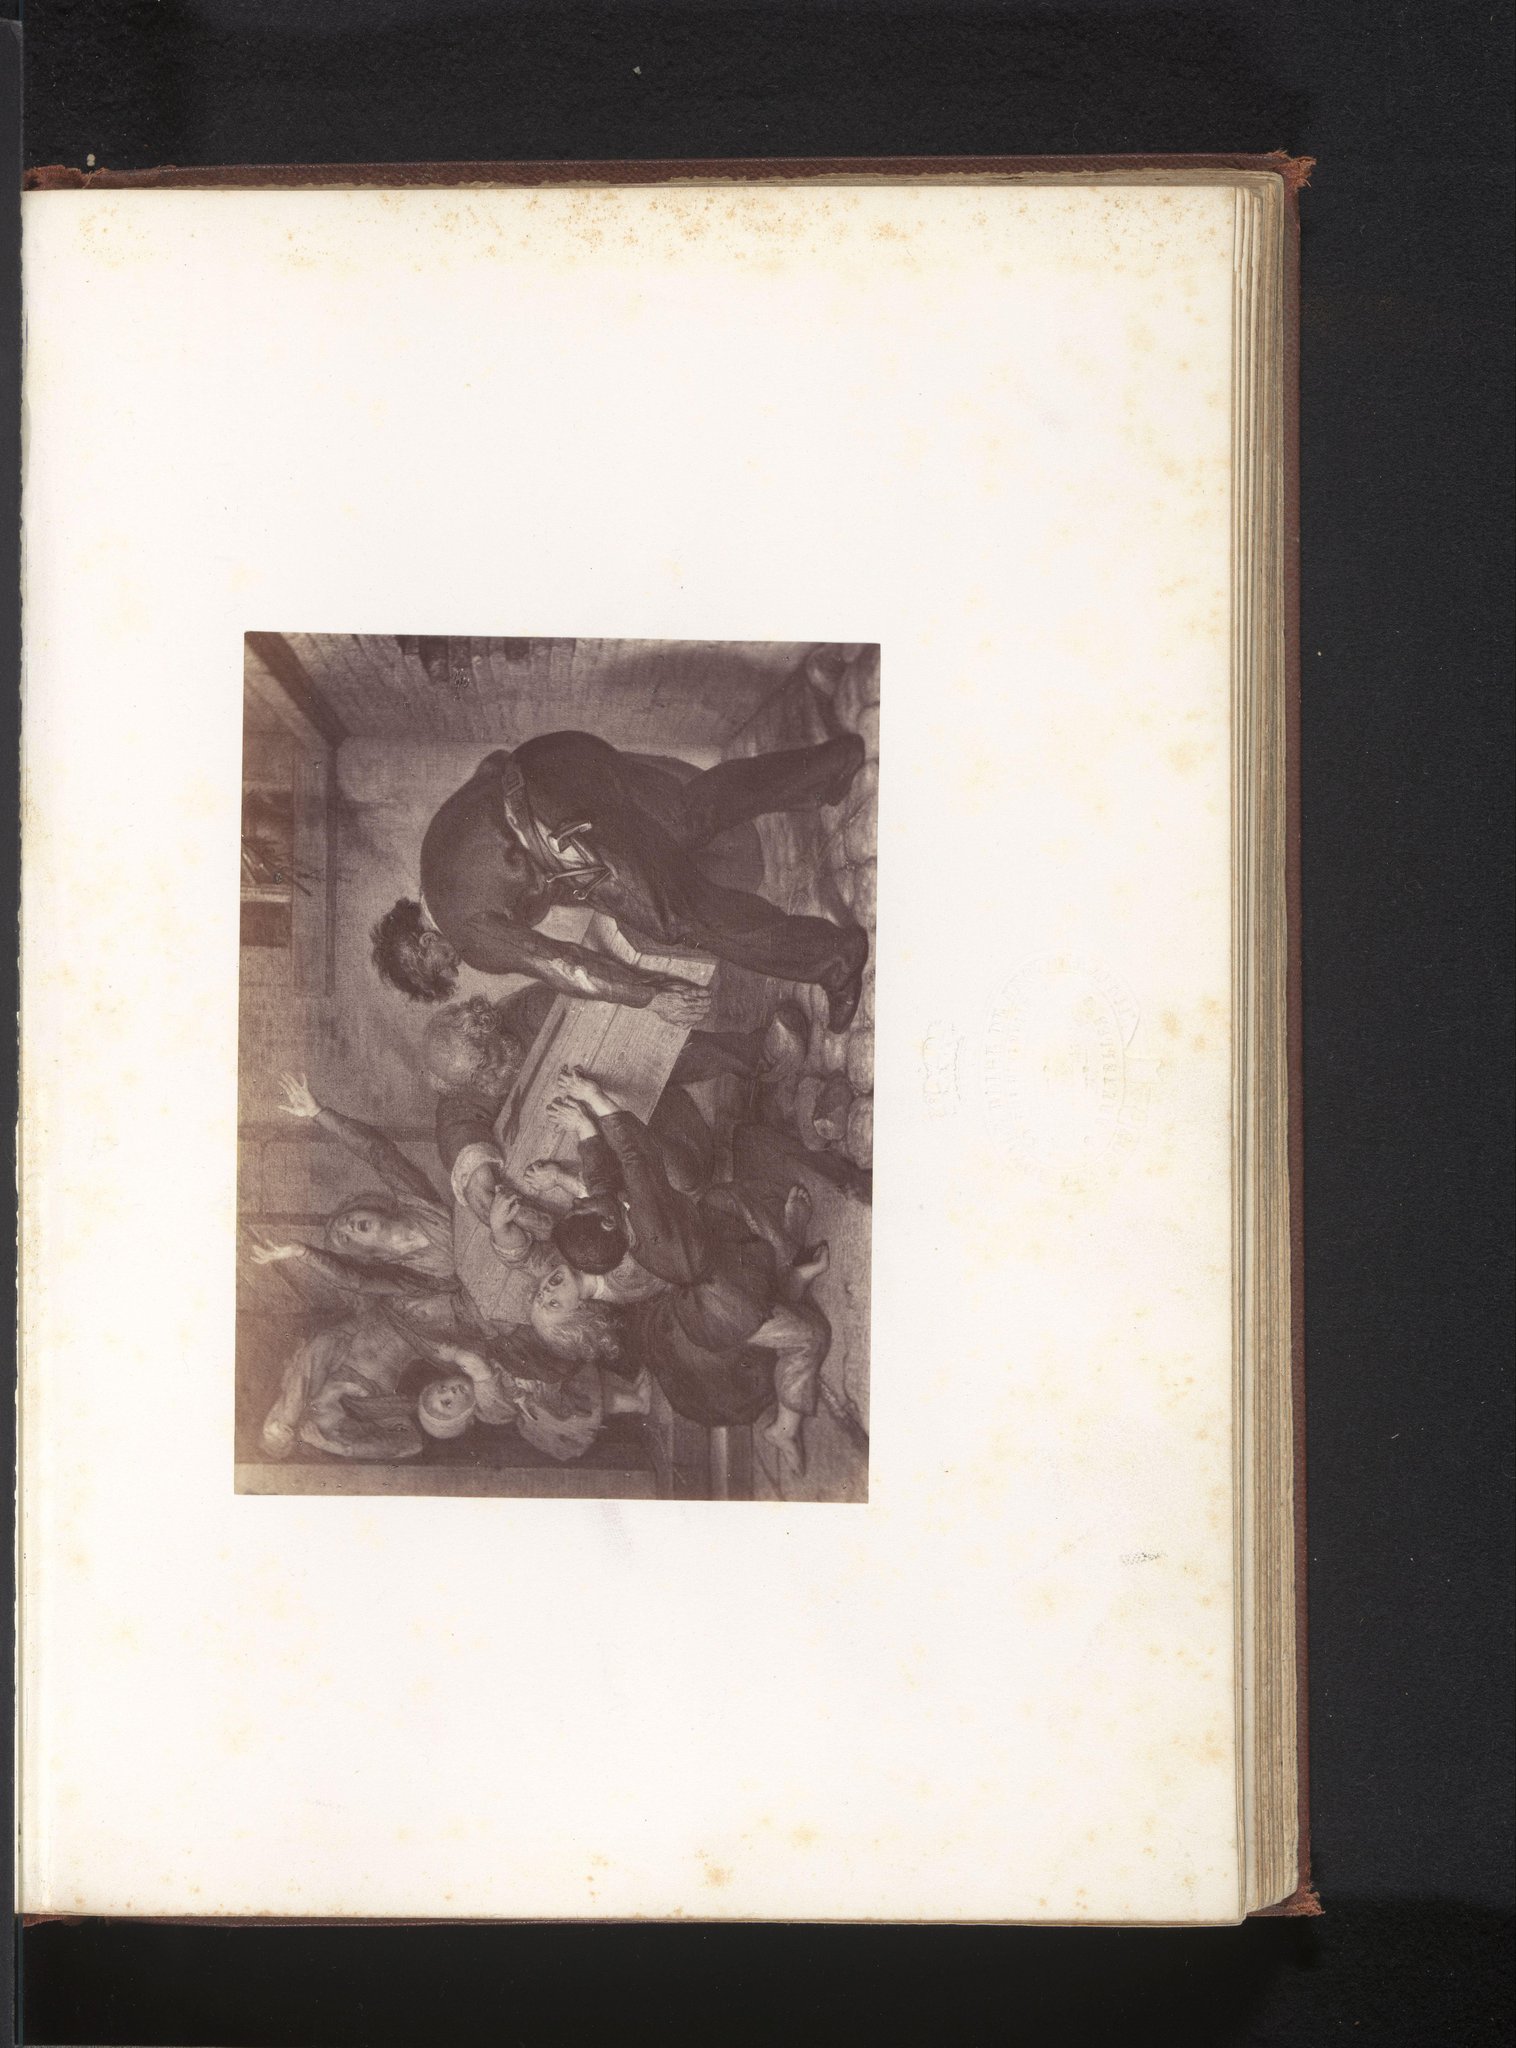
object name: photograph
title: Fotoreproductie van De wezen door Antoine Wiertz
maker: edmond fierlants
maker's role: fotograaf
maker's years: 1819-1869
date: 1863-1868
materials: photographic support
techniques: albumen print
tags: coffin, orphans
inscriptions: check stamp: ‘SOCIÉTÉ ROYALE BELGE DE PHOTOGRAPHIE/ 69, RUE KEYENVELD/ BRUXELLES’